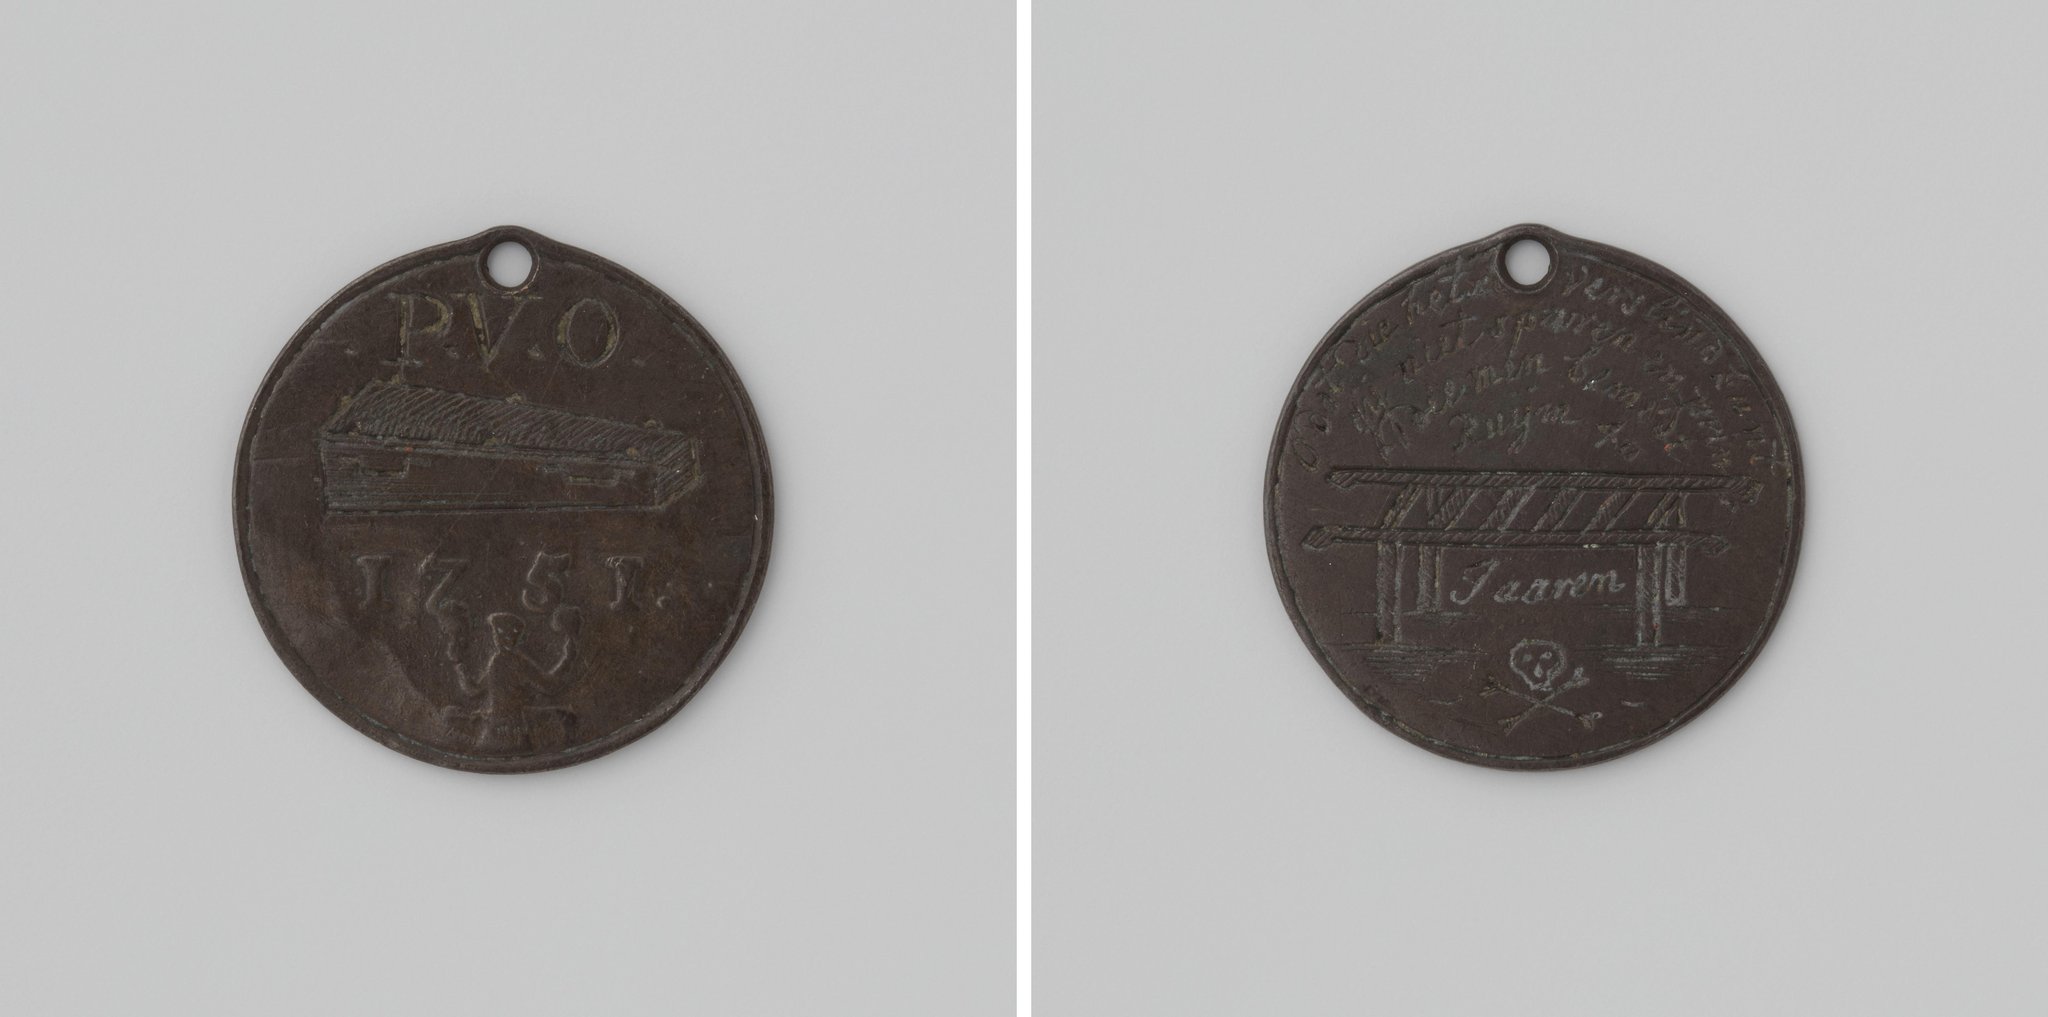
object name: history medal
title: Overlijden van Willem IV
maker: Anonymous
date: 1751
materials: copper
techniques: engraving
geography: netherlands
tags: willem iv (prins van oranje-nassau)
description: Koperen penning met gat erin. Voorzijde: lijkkist onder opschrift boven jaartal; daaronder persoon met twee voorwerpen in omhoog gestoken handen. Keerzijde: baaren onder opschrift boven doodshoofd